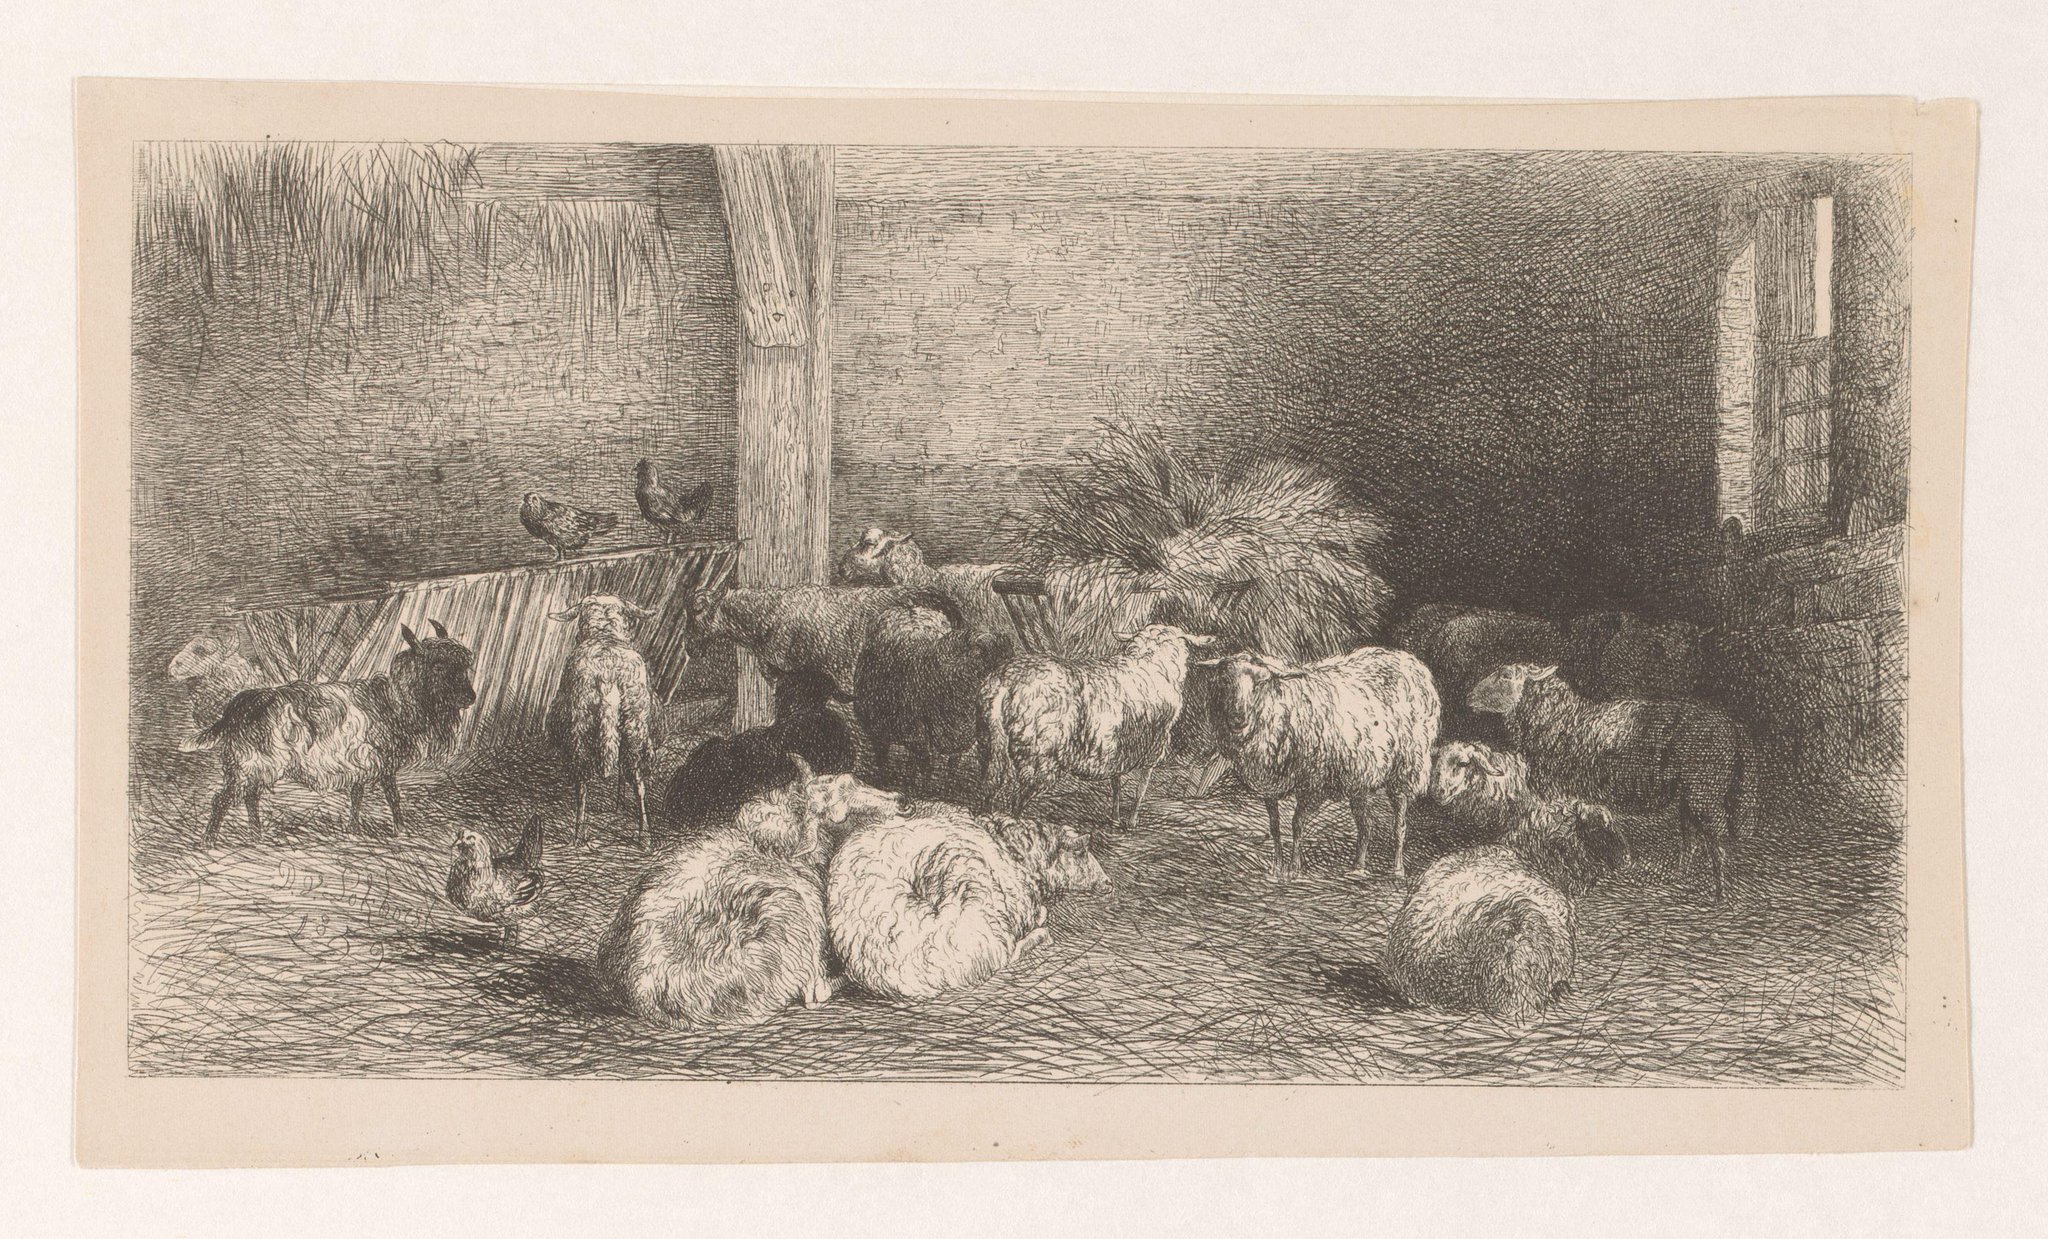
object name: print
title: Stalinterieur met schapen, geiten en kippen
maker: dirk van lokhorst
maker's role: draughtsman, painter, print maker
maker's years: 1818-1893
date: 1859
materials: paper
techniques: lithograph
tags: barn - aa - civic architecture: inside, sheep, fowl (cock, hen, chicken, etc.), stall, stable, goat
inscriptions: collector's mark: Lugt 2228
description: De dieren staan bij ruiven met hooi. Rechts een raam.